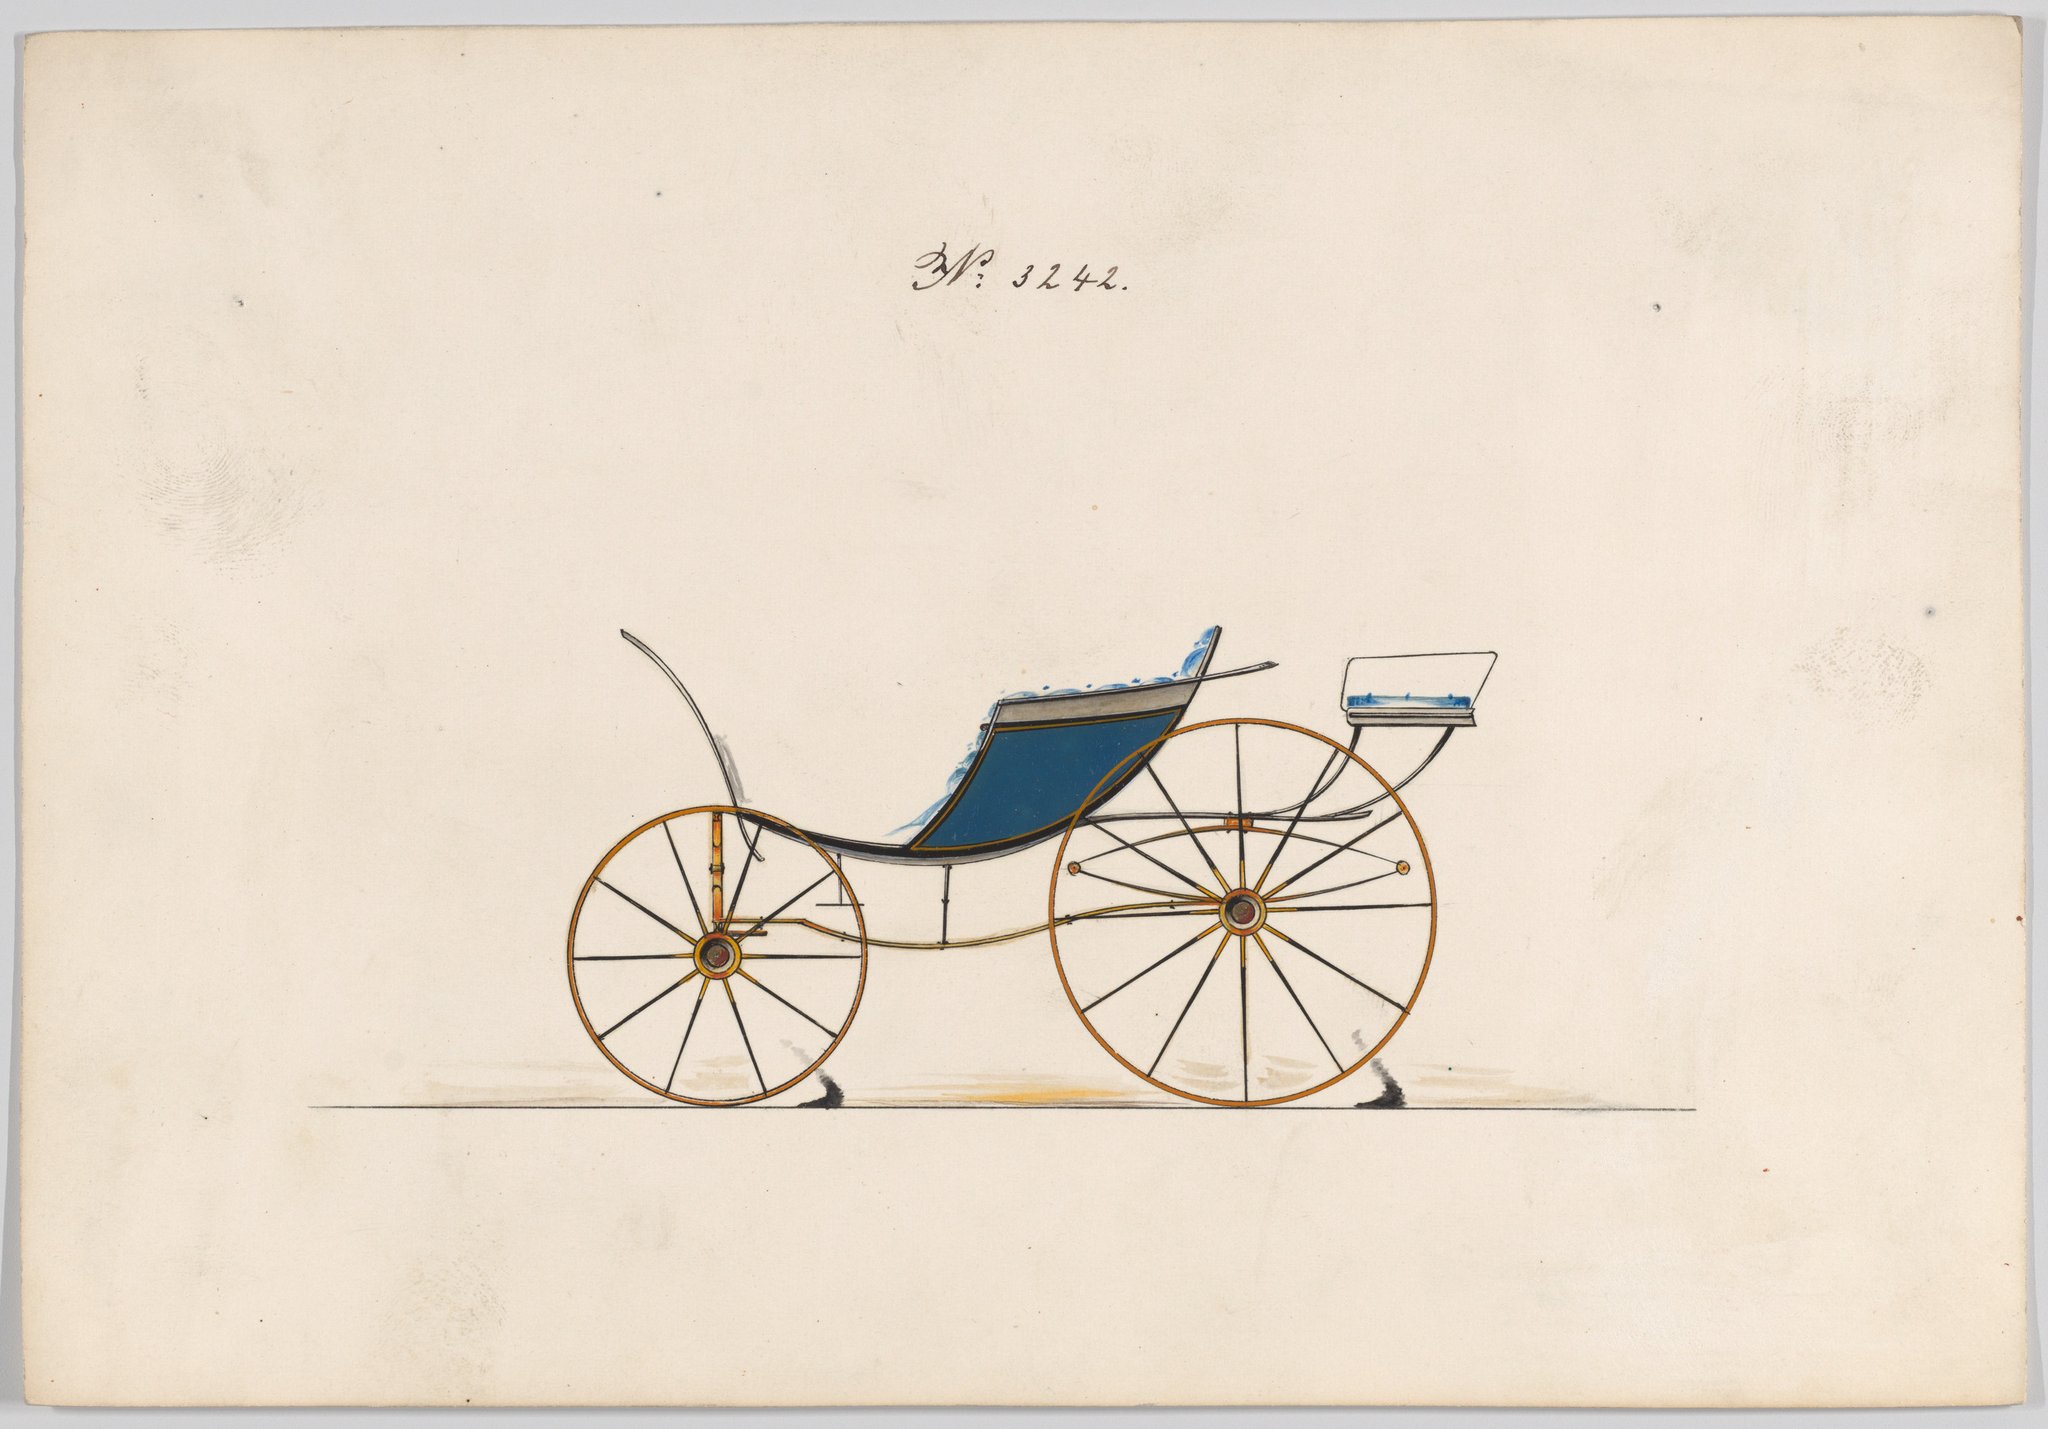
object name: drawing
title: Design for Pony Phaeton, no. 3242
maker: brewster & co.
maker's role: manufacturer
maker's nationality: american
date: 1876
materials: gouache, ink, watercolor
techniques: pen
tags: carriages